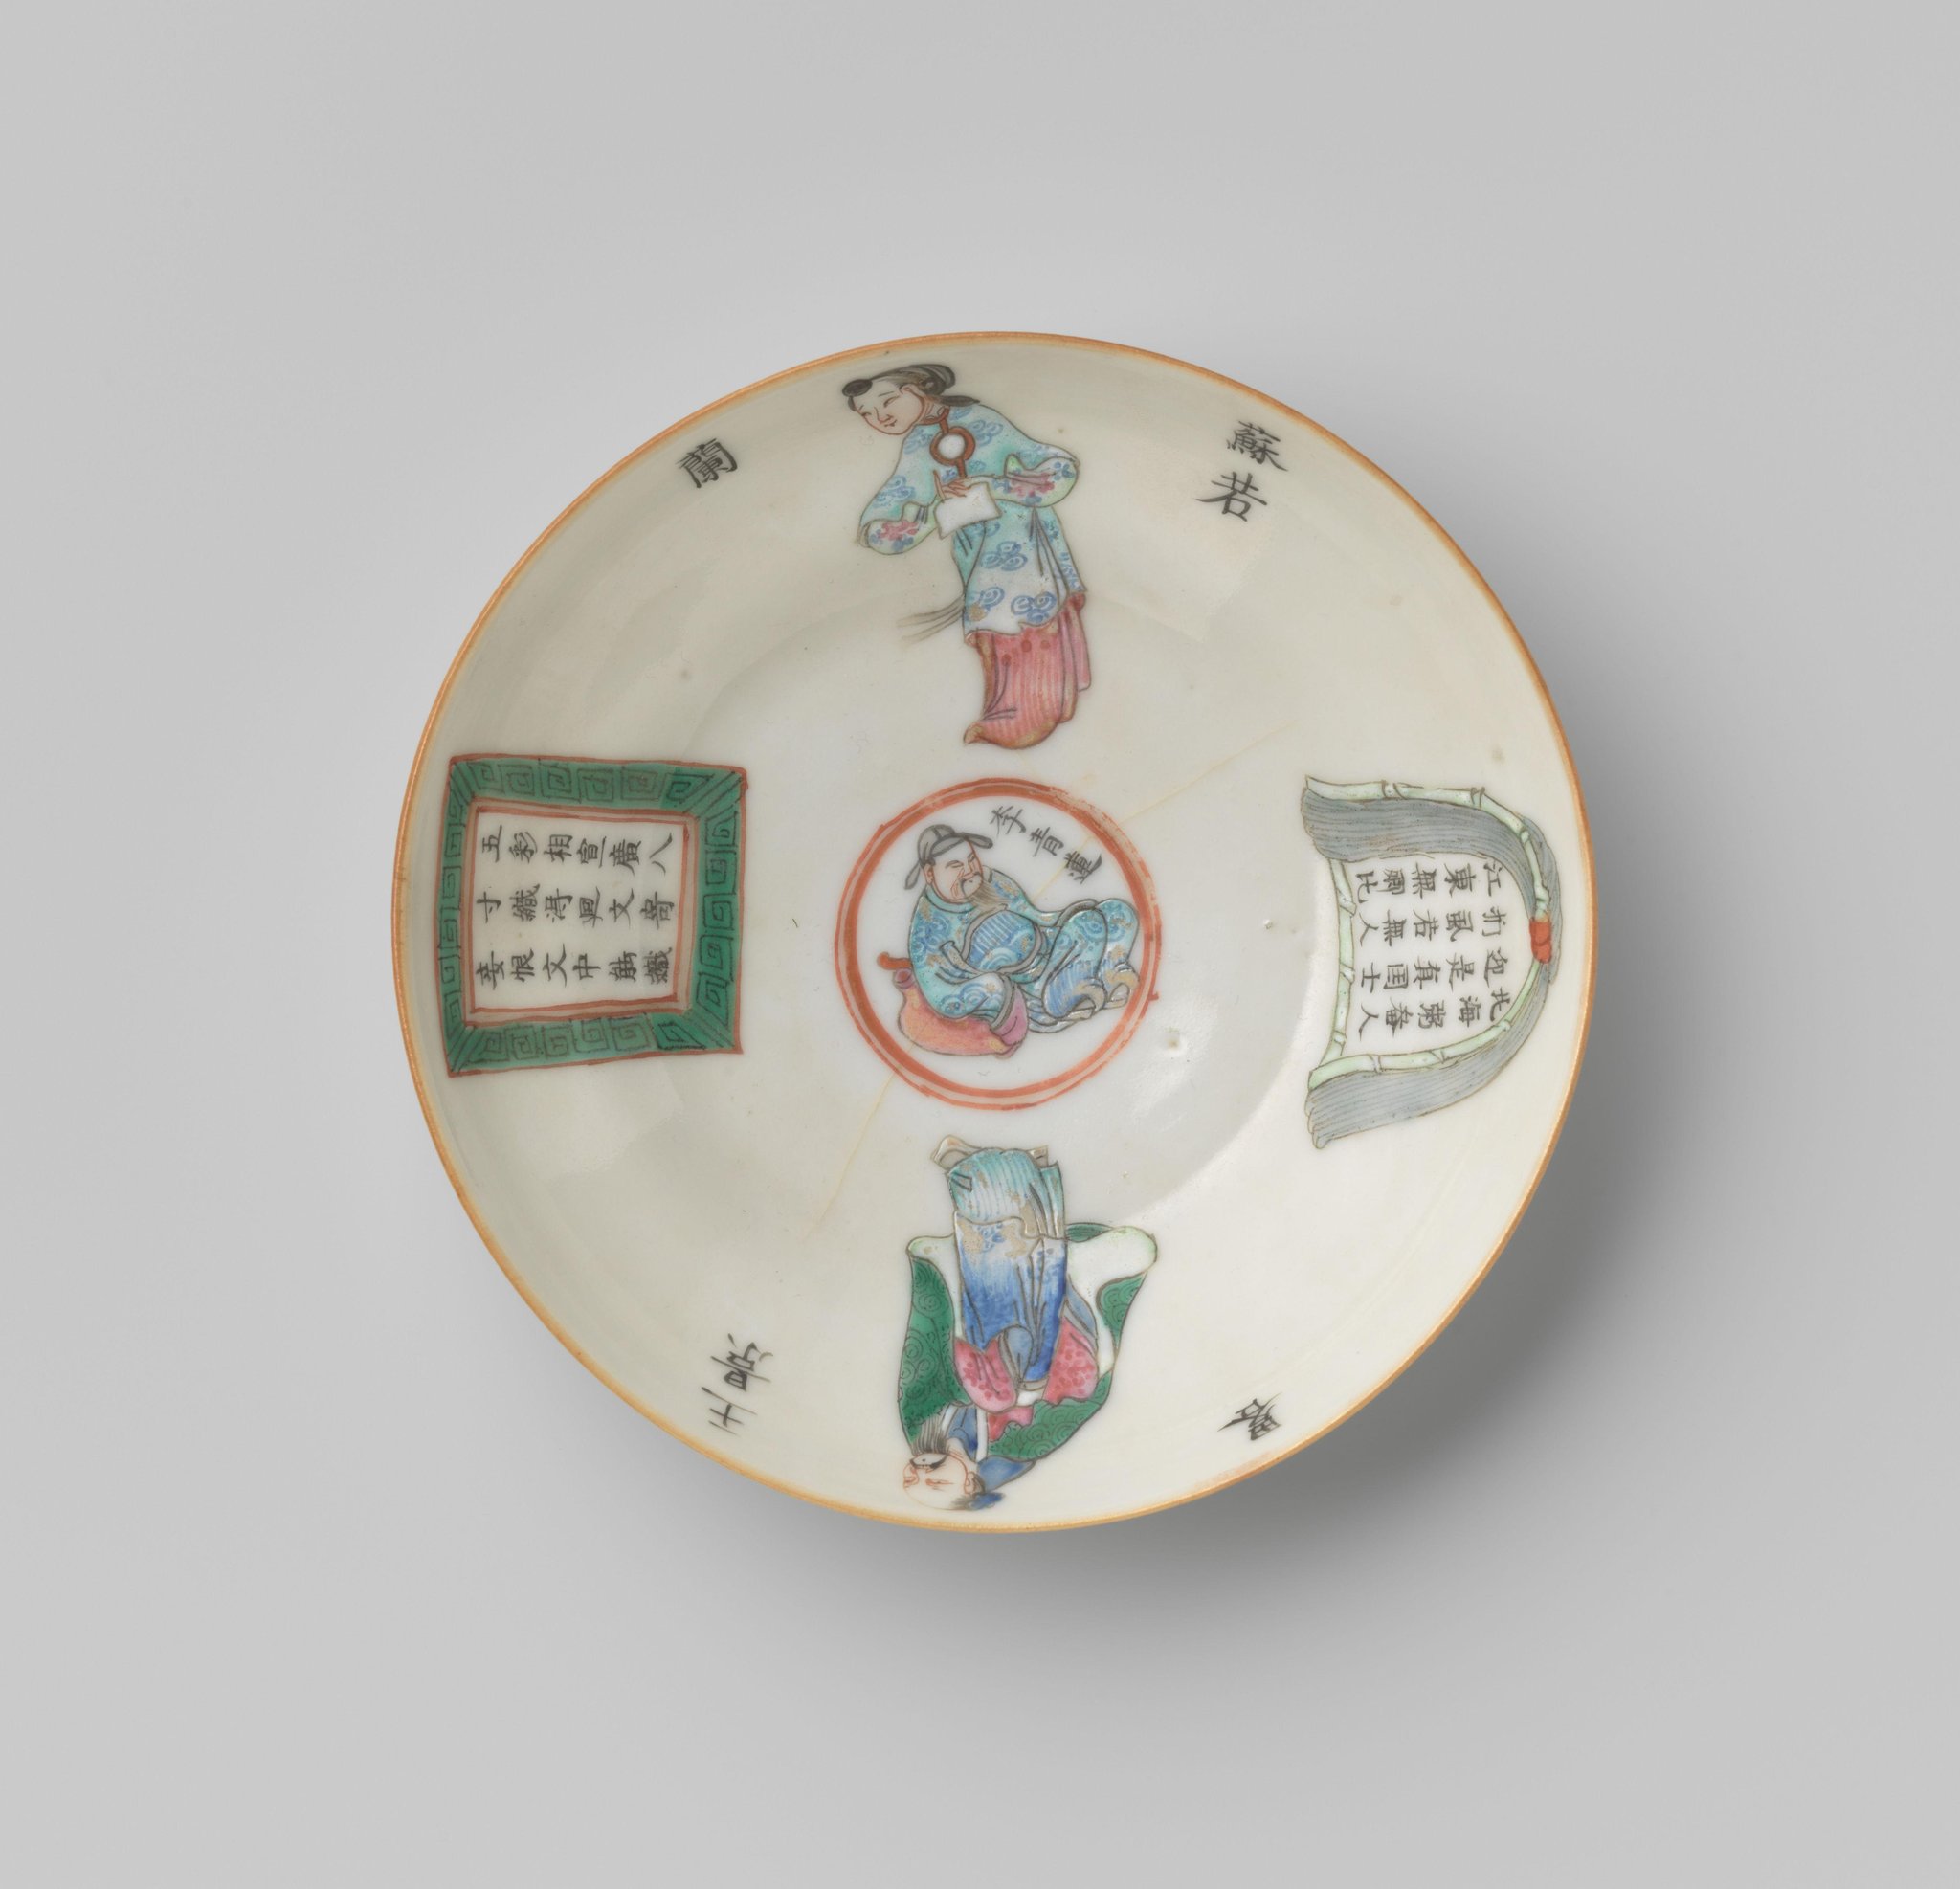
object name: kop en schotel, kop en schotel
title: Saucer with figures, a go-bord and inscriptions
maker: Anonymous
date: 1800-1899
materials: glaze, gold, paint, porcelain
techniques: firing, gilding, turning, vitrification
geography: china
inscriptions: mark: ‘大 清 道 光 年 製’, mark: ‘大 清 咸 豐 年 製’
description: Kop en schotel, met deksels met chinese figuren en karakters in kleuren.